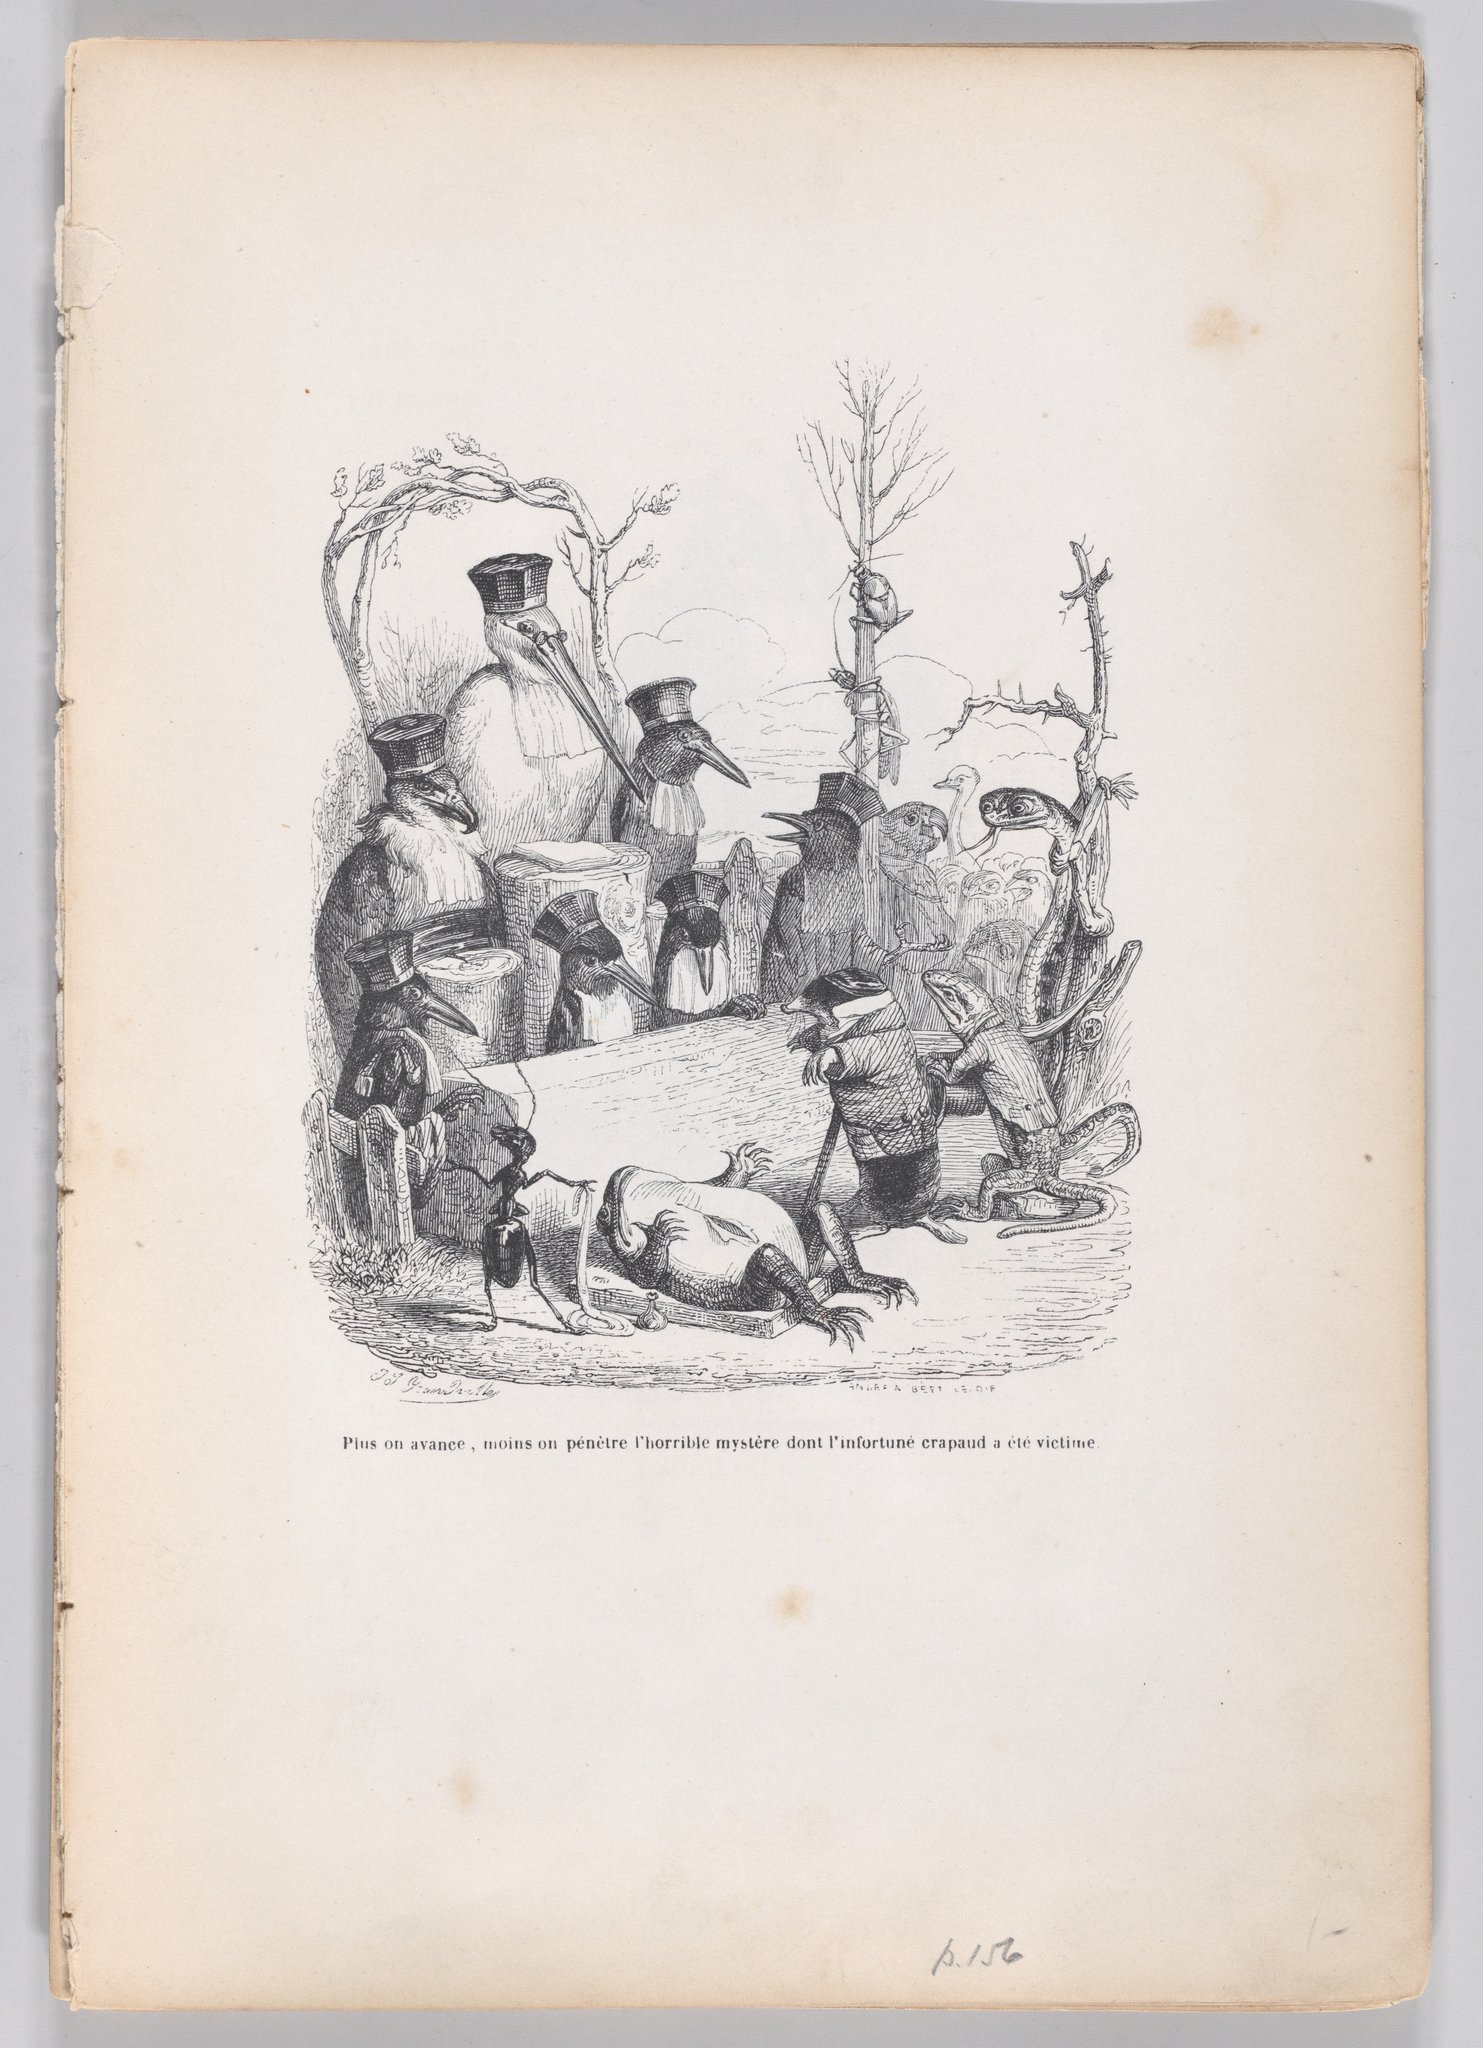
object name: print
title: The further we go, the less we penetrate the horrible mystery of which the unfortunate toad was a victim, from "Scenes from the Private and Public Life of Animals"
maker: j. j. grandville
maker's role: illustrator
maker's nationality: french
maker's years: 1803-1847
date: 1837-1847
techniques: engraving